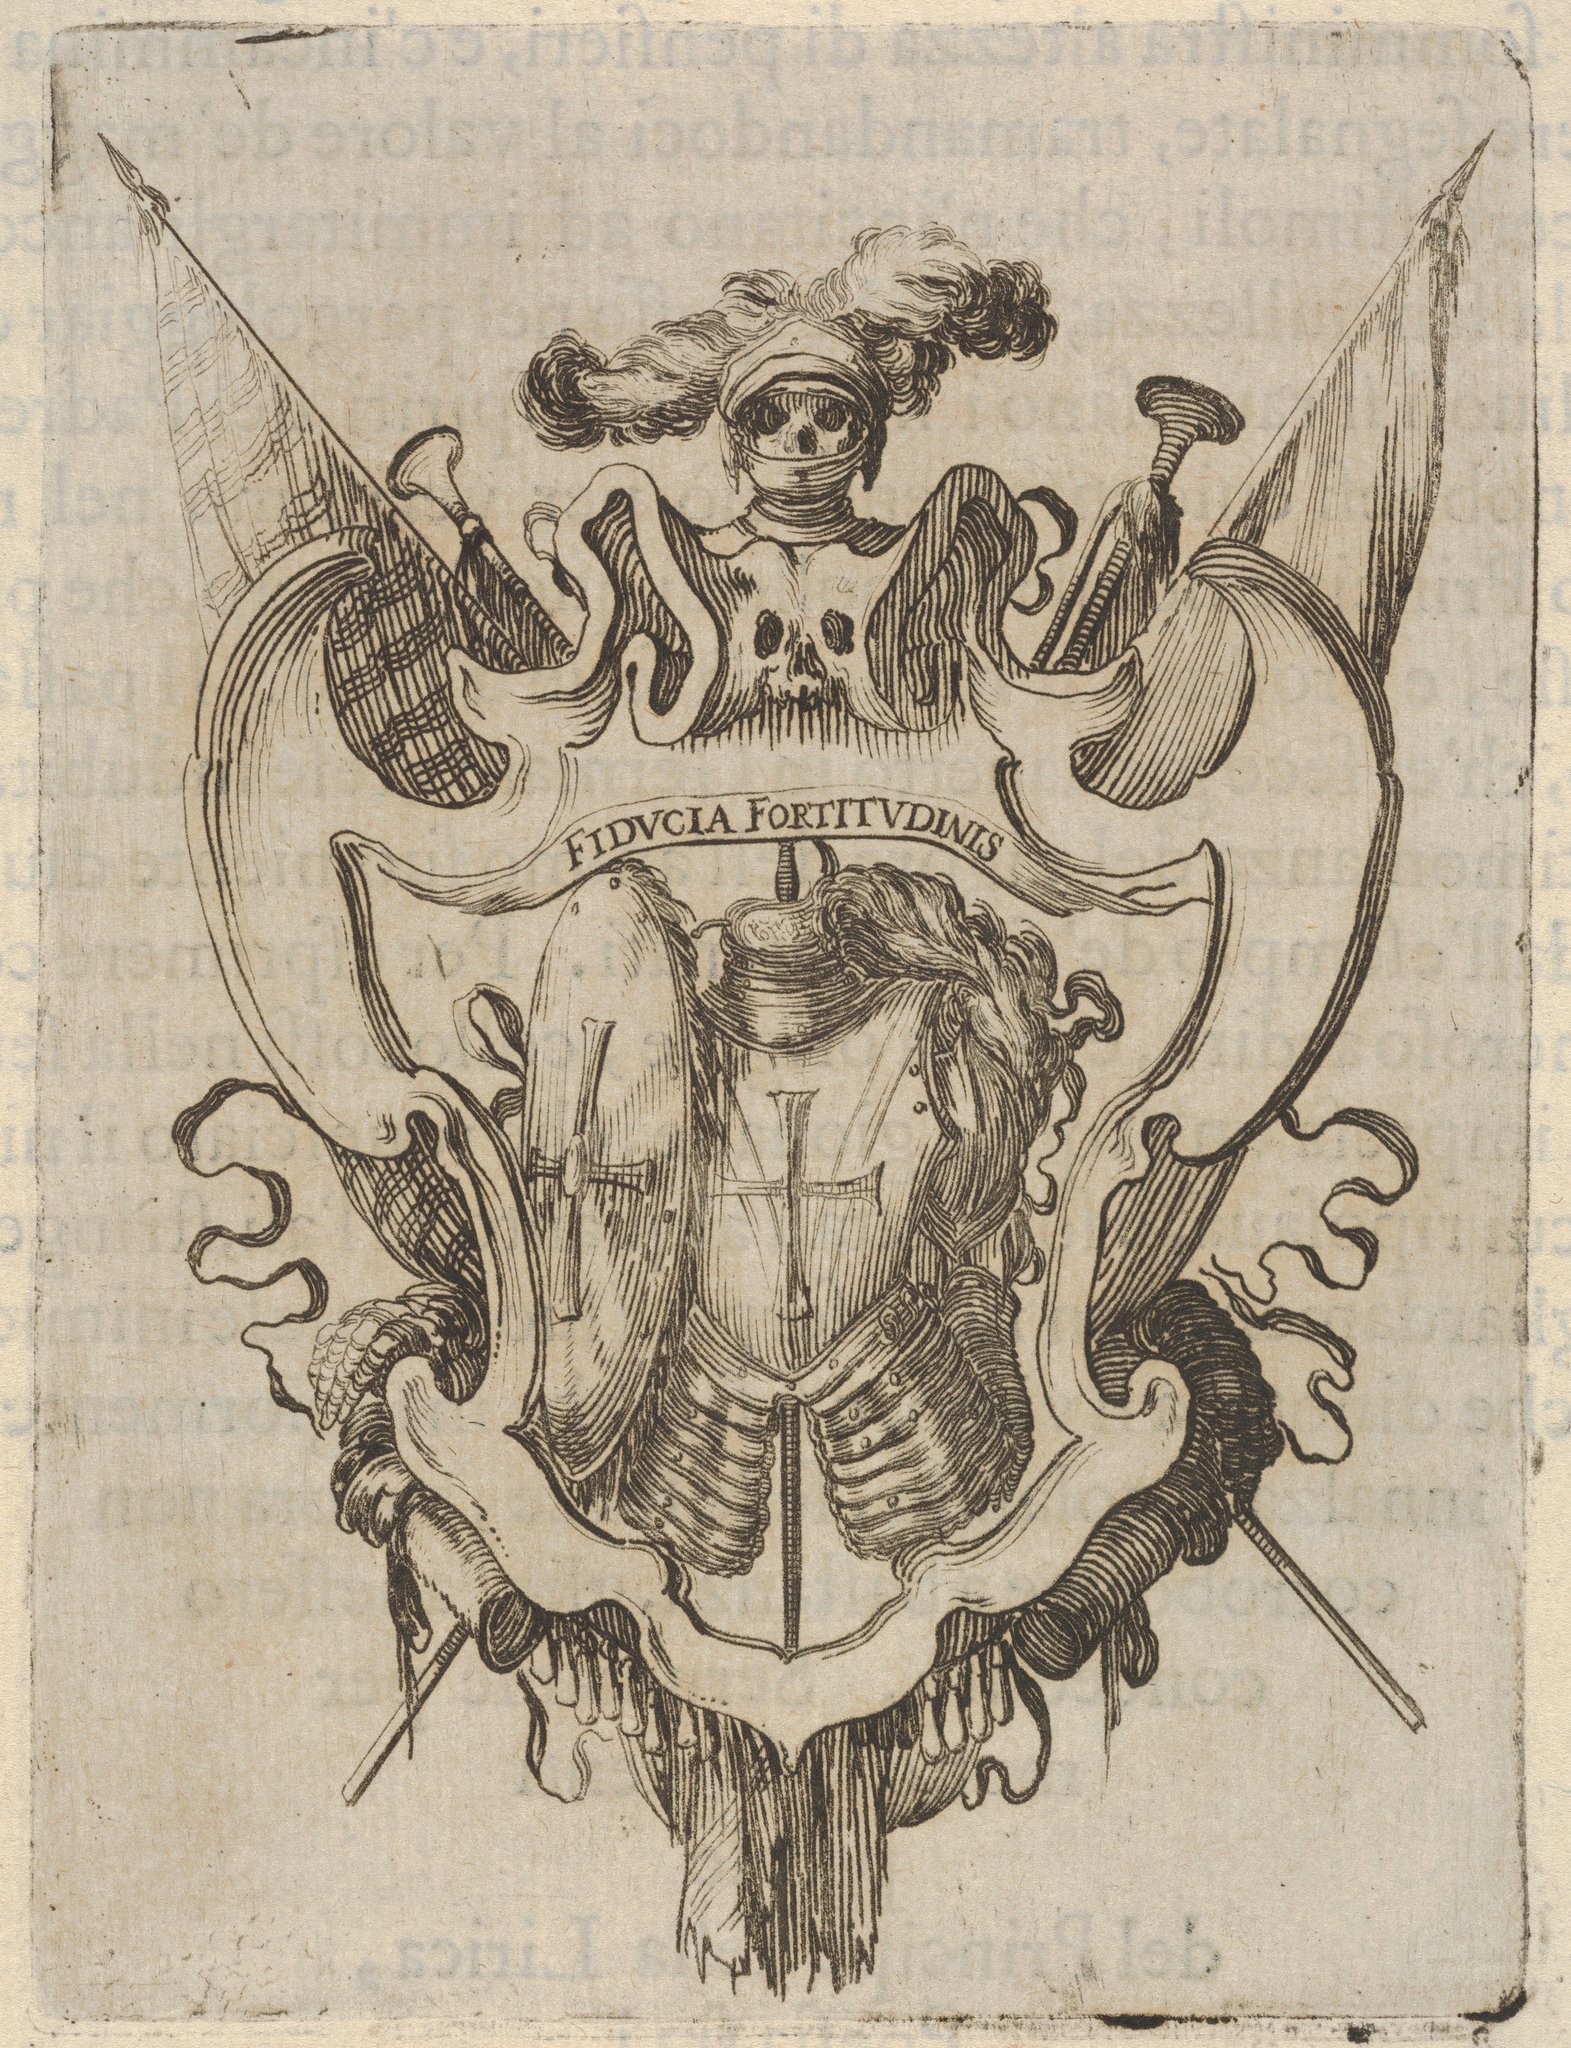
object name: print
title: A cartouche with armor, a skull with armor and a helmet with feathers at top, from "Eight Emblems for the Funeral of Francesco de Medici" (Huit emblèmes pour les funérailles du prince François de Médicis)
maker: stefano della bella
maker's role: artist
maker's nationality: italian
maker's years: 1610-1664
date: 1640-1660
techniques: etching, letterpress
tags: armor,helmets,cartouches,skulls,emblems